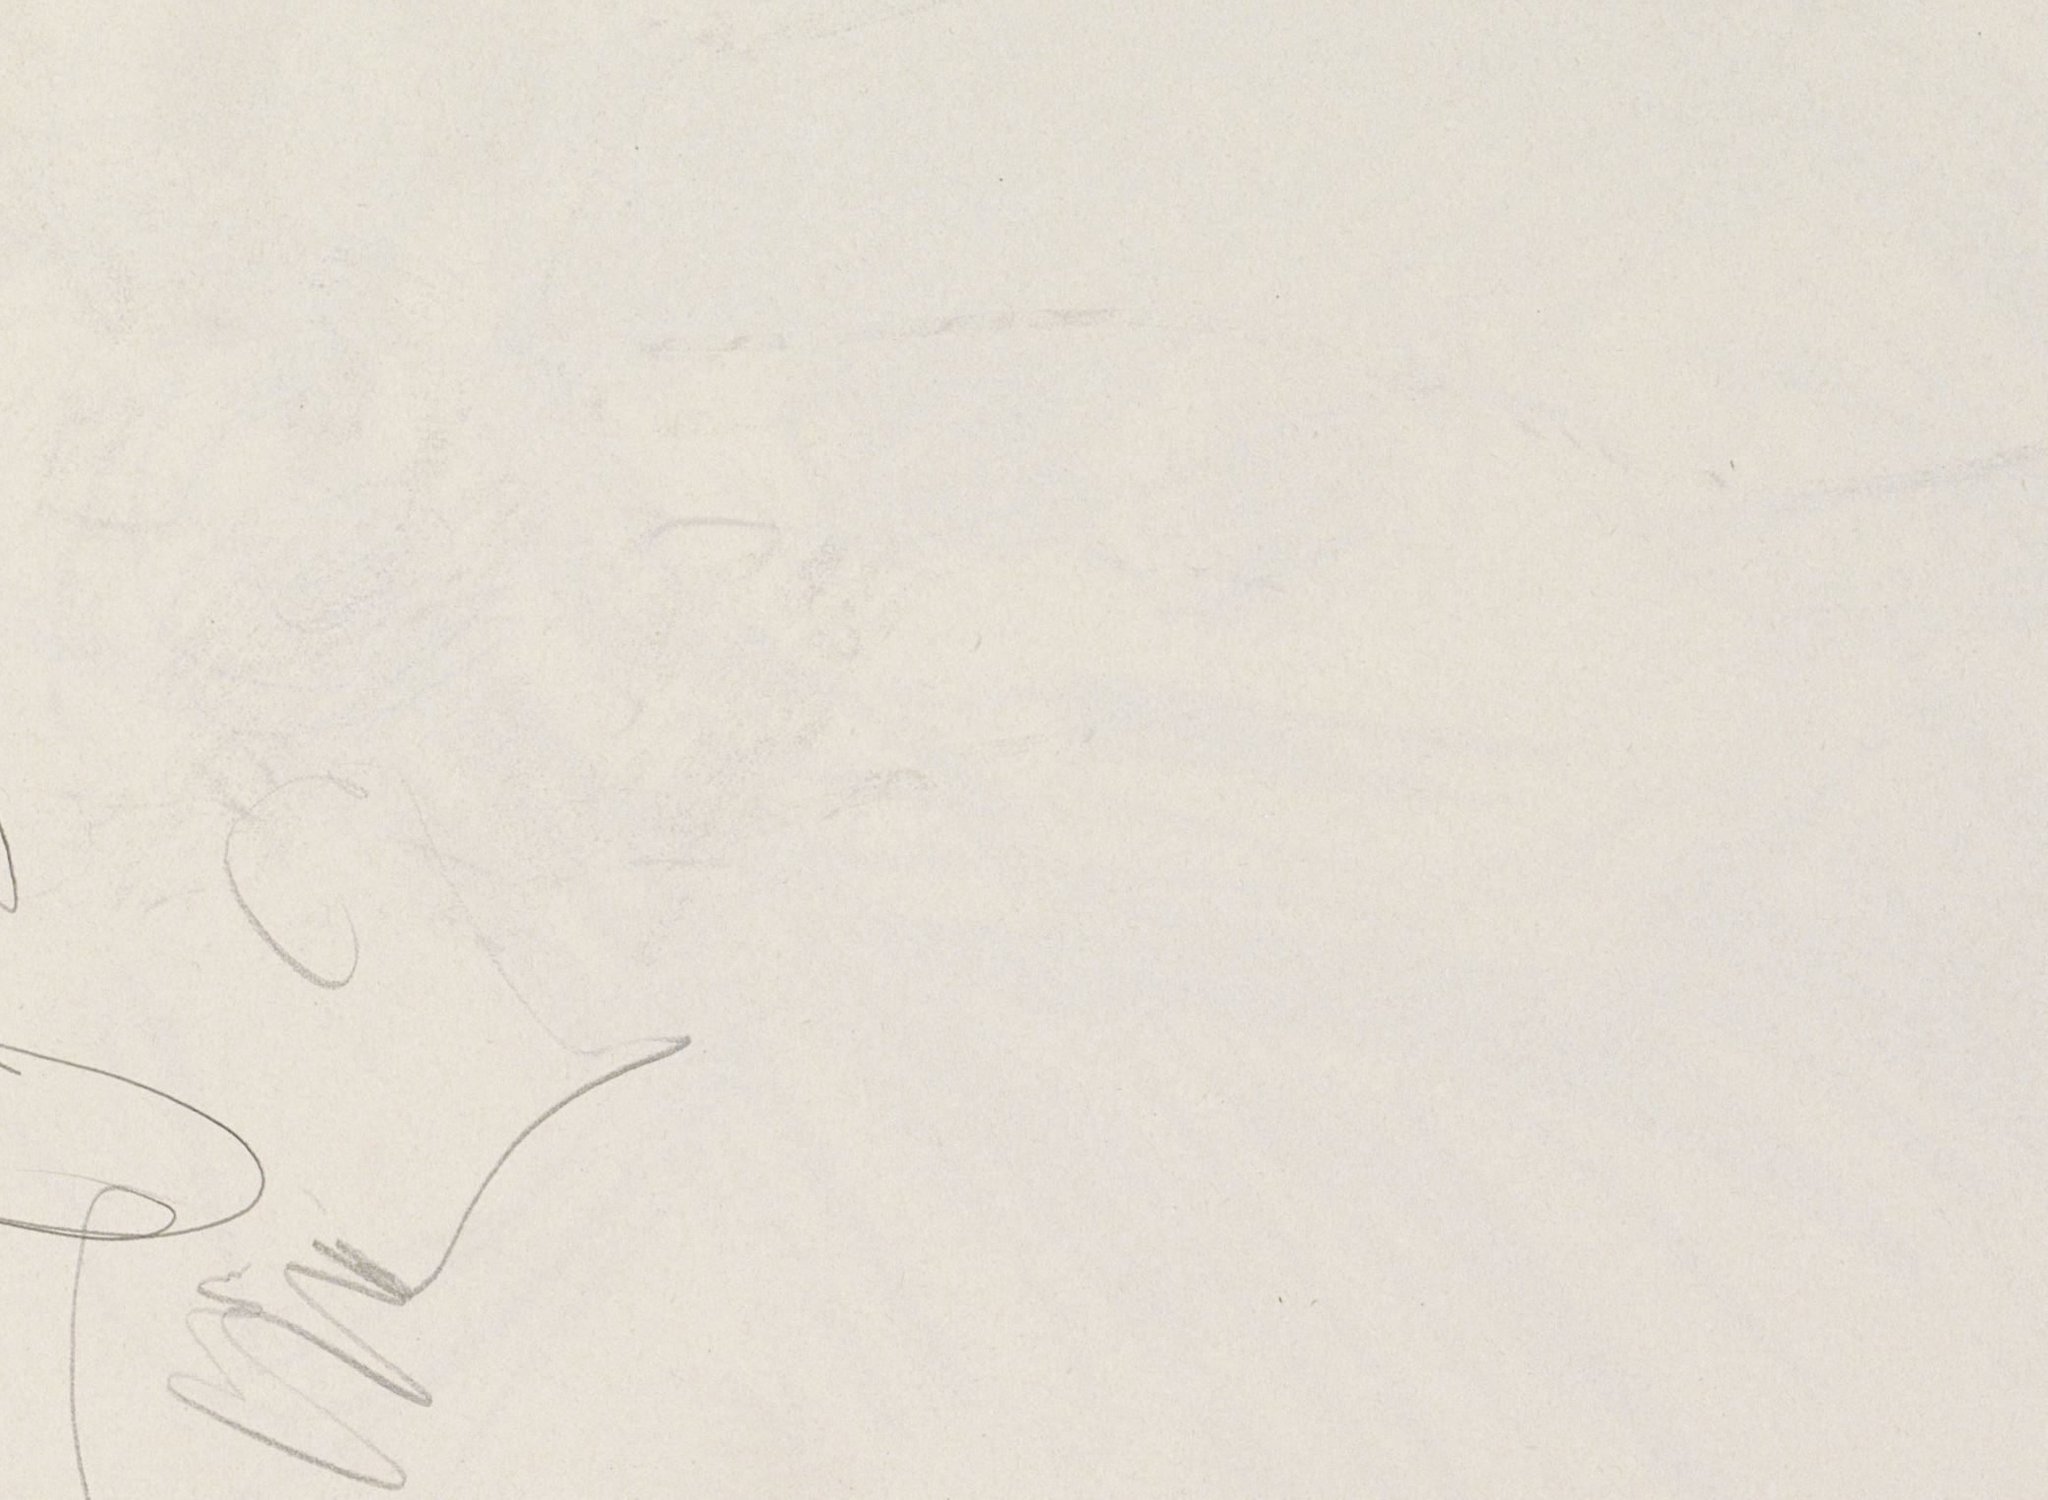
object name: sketchbook leaf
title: Studie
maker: isaac israels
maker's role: draughtsman, painter, print maker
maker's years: 1865-1934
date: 1915-1934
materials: paper, pencil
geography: the hague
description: Blad 3 verso uit schetsboek III met 36 bladen.